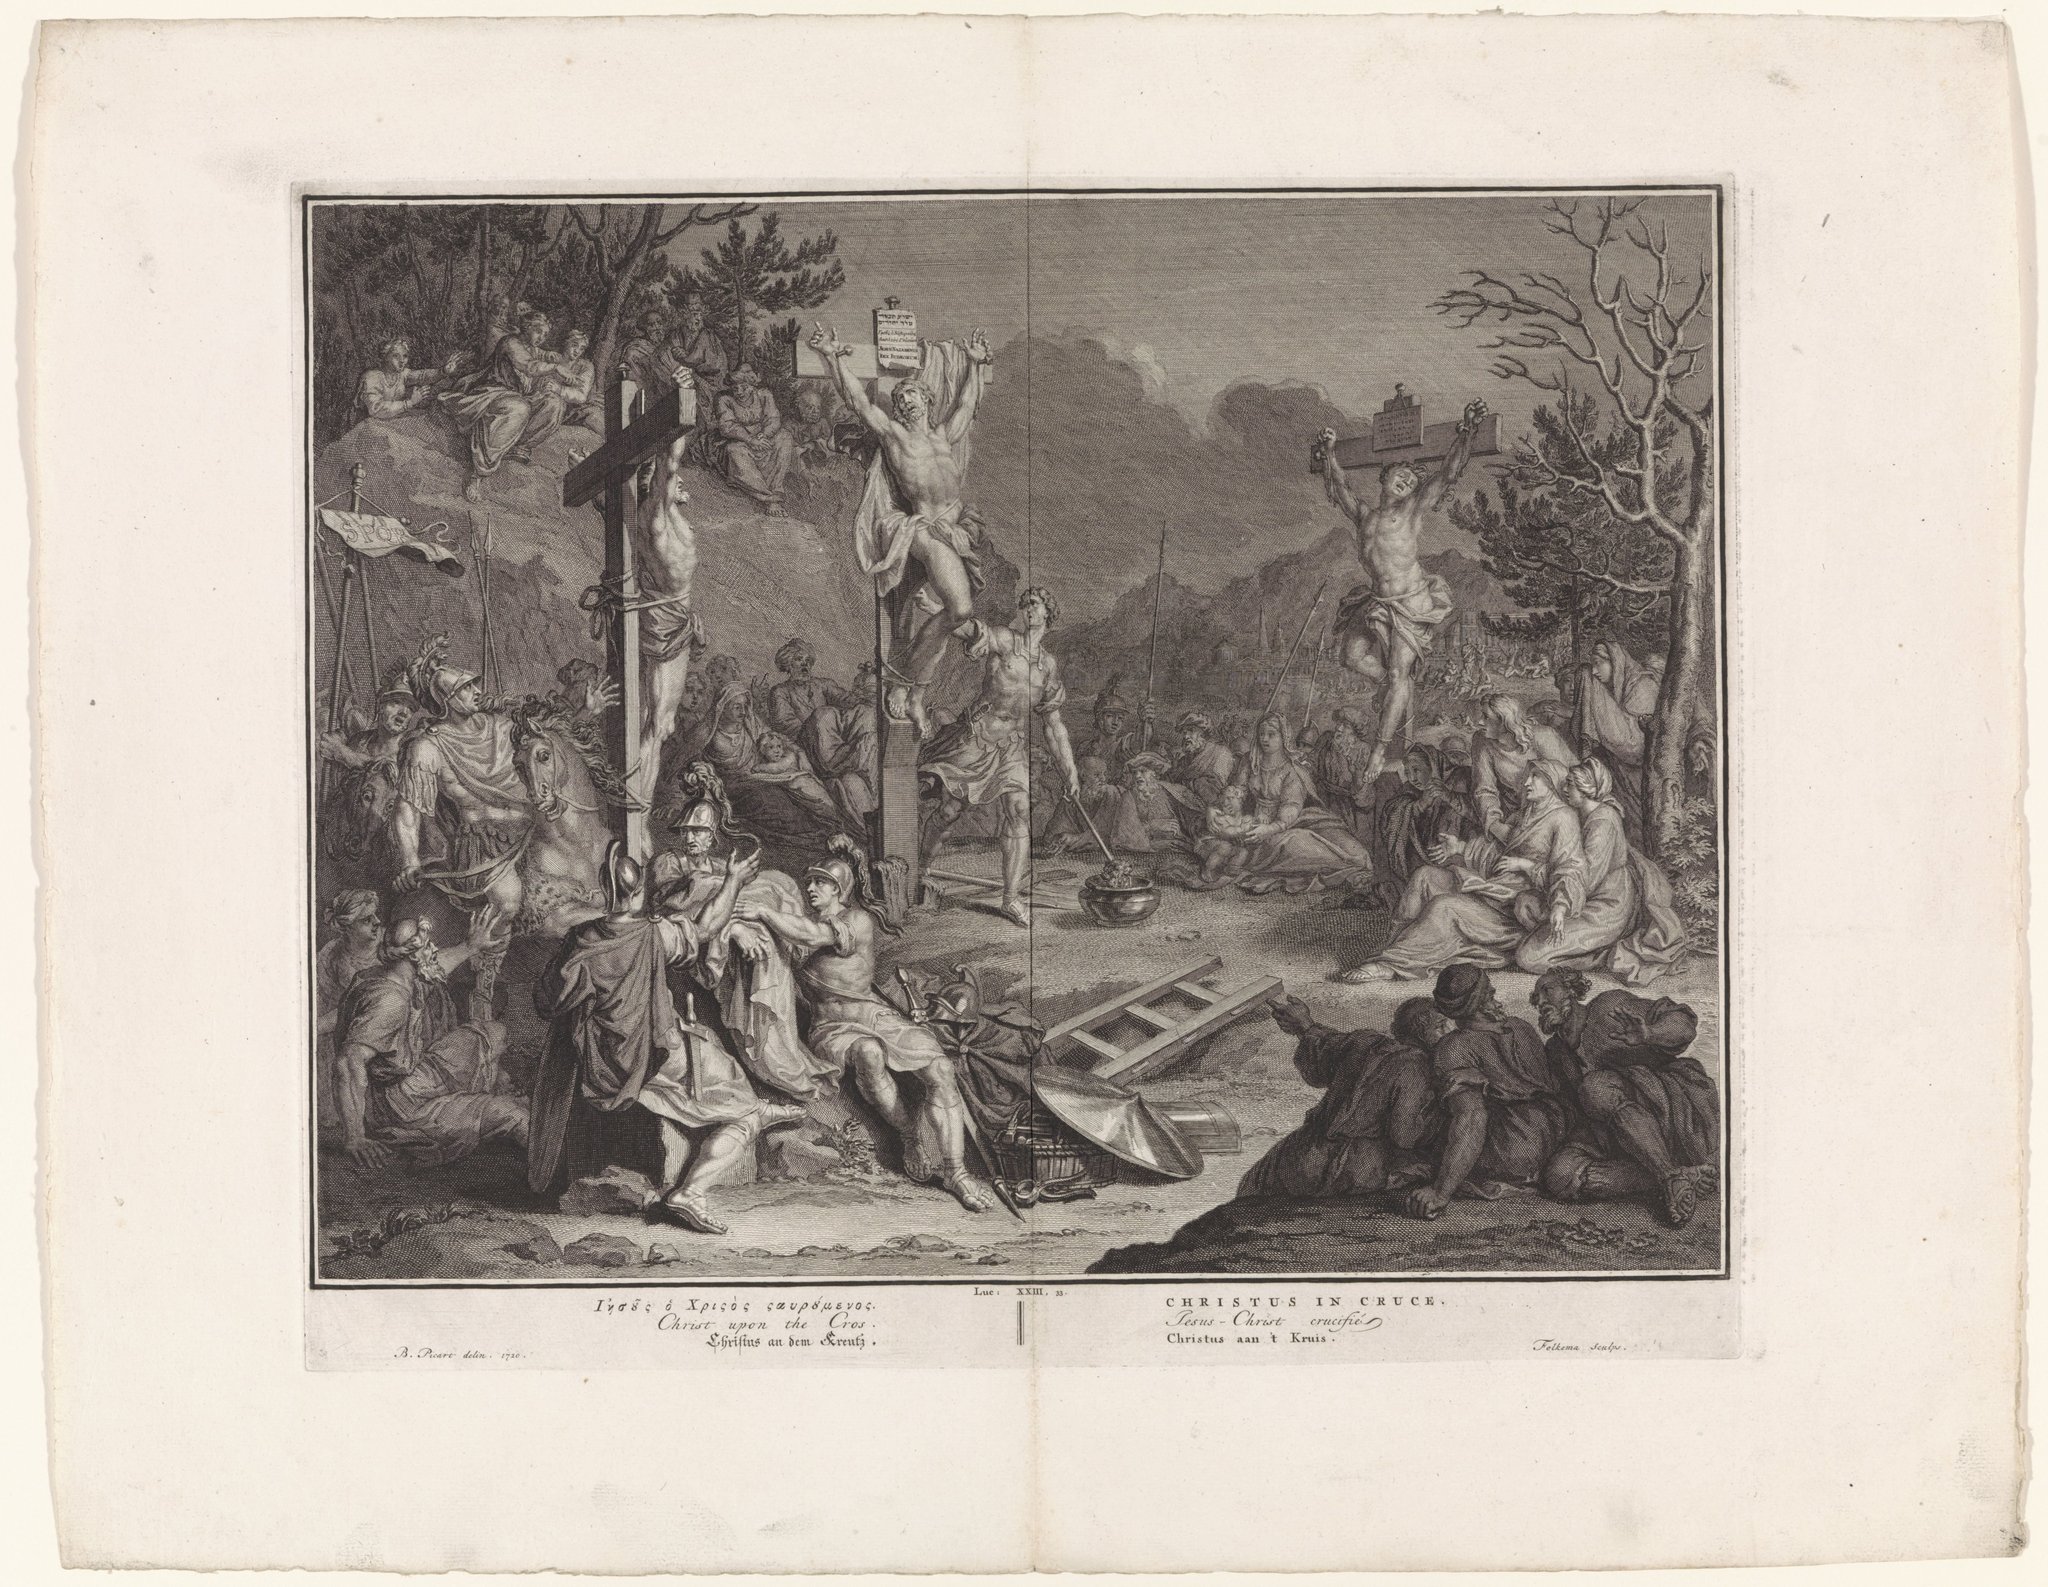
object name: book illustration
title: Kruisiging van Christus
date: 1720-1728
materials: paper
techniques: engraving, etching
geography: amsterdam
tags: christ on the cross combined with other scenes from the passion - dd - the three crosses, the crucifixion of christ: christ's death on the cross; golgotha (matthew 27:45-58; mark 15:33-45; luke 23:44-52; john 19:25-38)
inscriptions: inscription: ‘Utrechts Fundatie huijs’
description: Christus aan het kruis tussen de twee gekruisigde misdadigers. Een soldaat heeft de spons in azijn gedoopt om Christus daarmee te drinken te geven. Op de voorgrond soldaten met de kleding van Christus, naast enkele werktuigen uit de Passie zoals nijptang, nagels en de ladder. Rechts Maria met gespreide armen en Johannes de Doper. Illustratie van de Bijbeltekst Luc. 23: 33. Onder de voorstelling de titel in het Hebreeuws, Engels, Duits, Latijn, Frans en Nederlands.